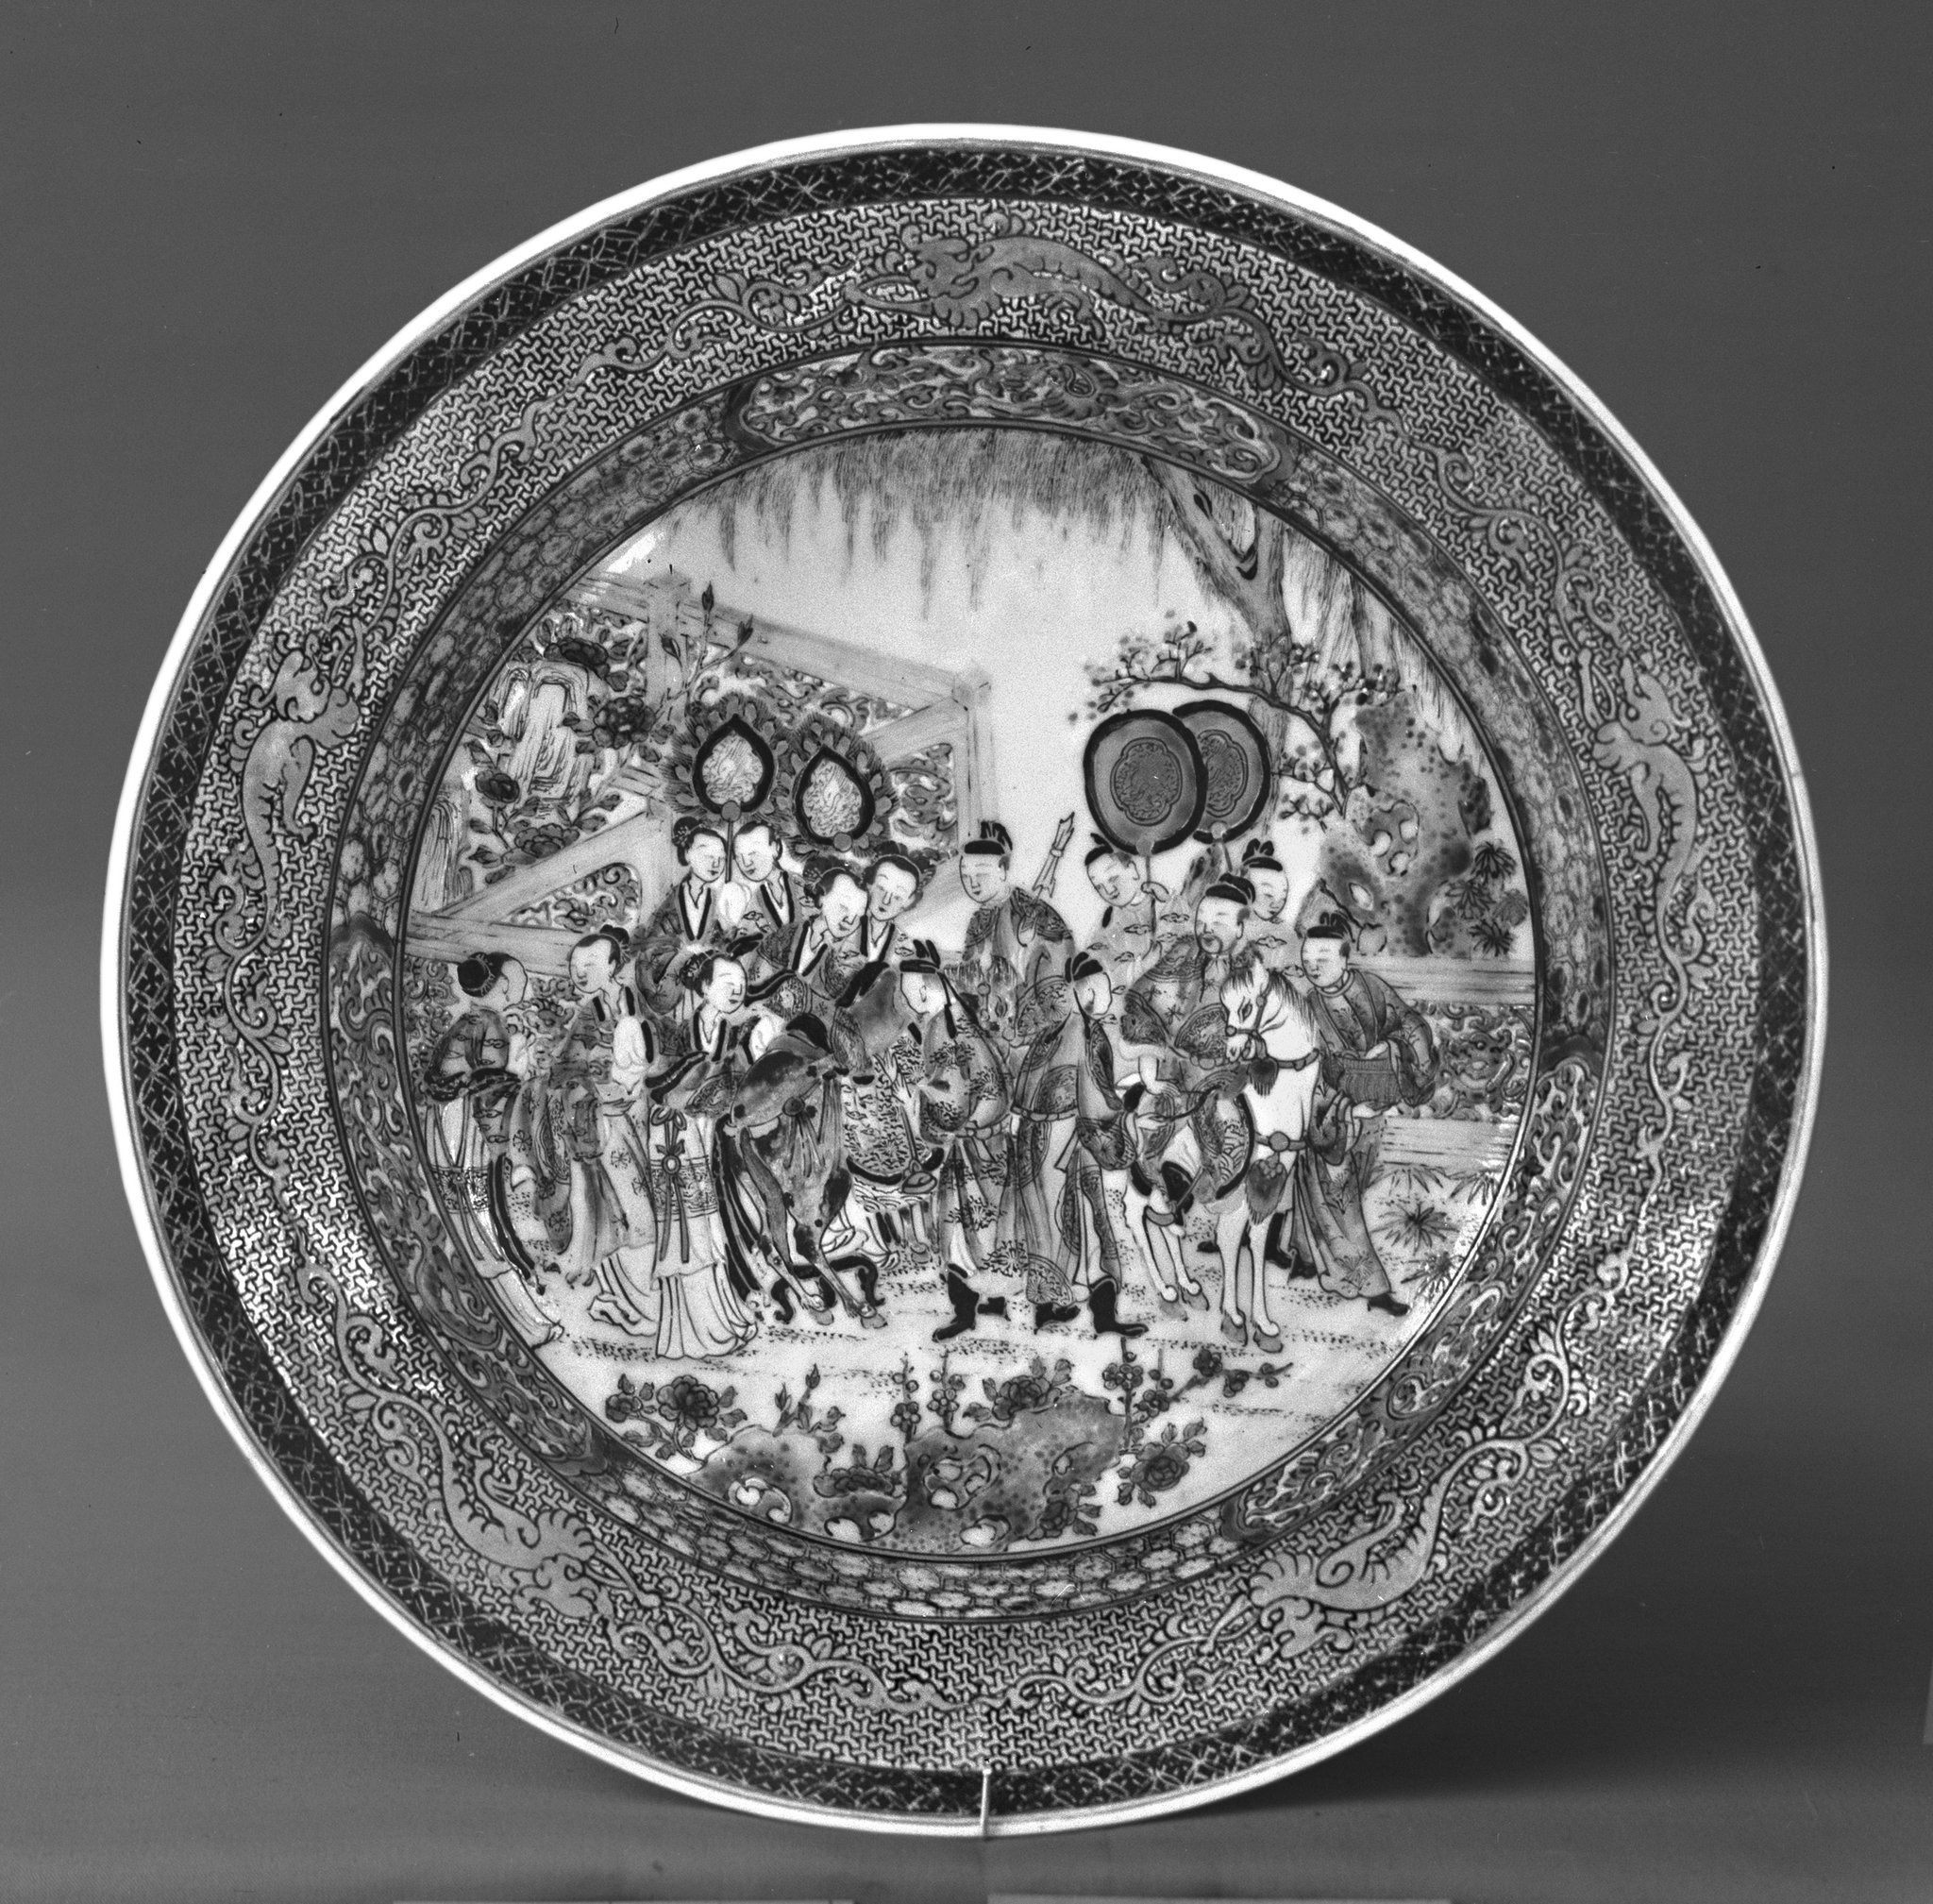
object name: plate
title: Plate with a narrative scene of the Consort Yang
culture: chinese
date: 1767-1800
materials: enamel, porcelain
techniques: overglaze, painting, polychrome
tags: men,women,horses